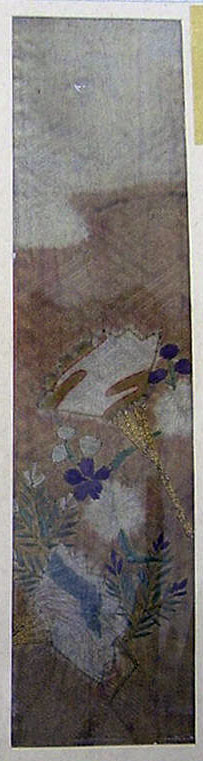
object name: piece from a kosode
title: Piece from a Kosode with Cloud, Fans, Plum Blossoms, and Young Pine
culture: japanese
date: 1615-1868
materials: silk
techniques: damask, dyeing, embroidery, painting, resist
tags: flowers,leaves